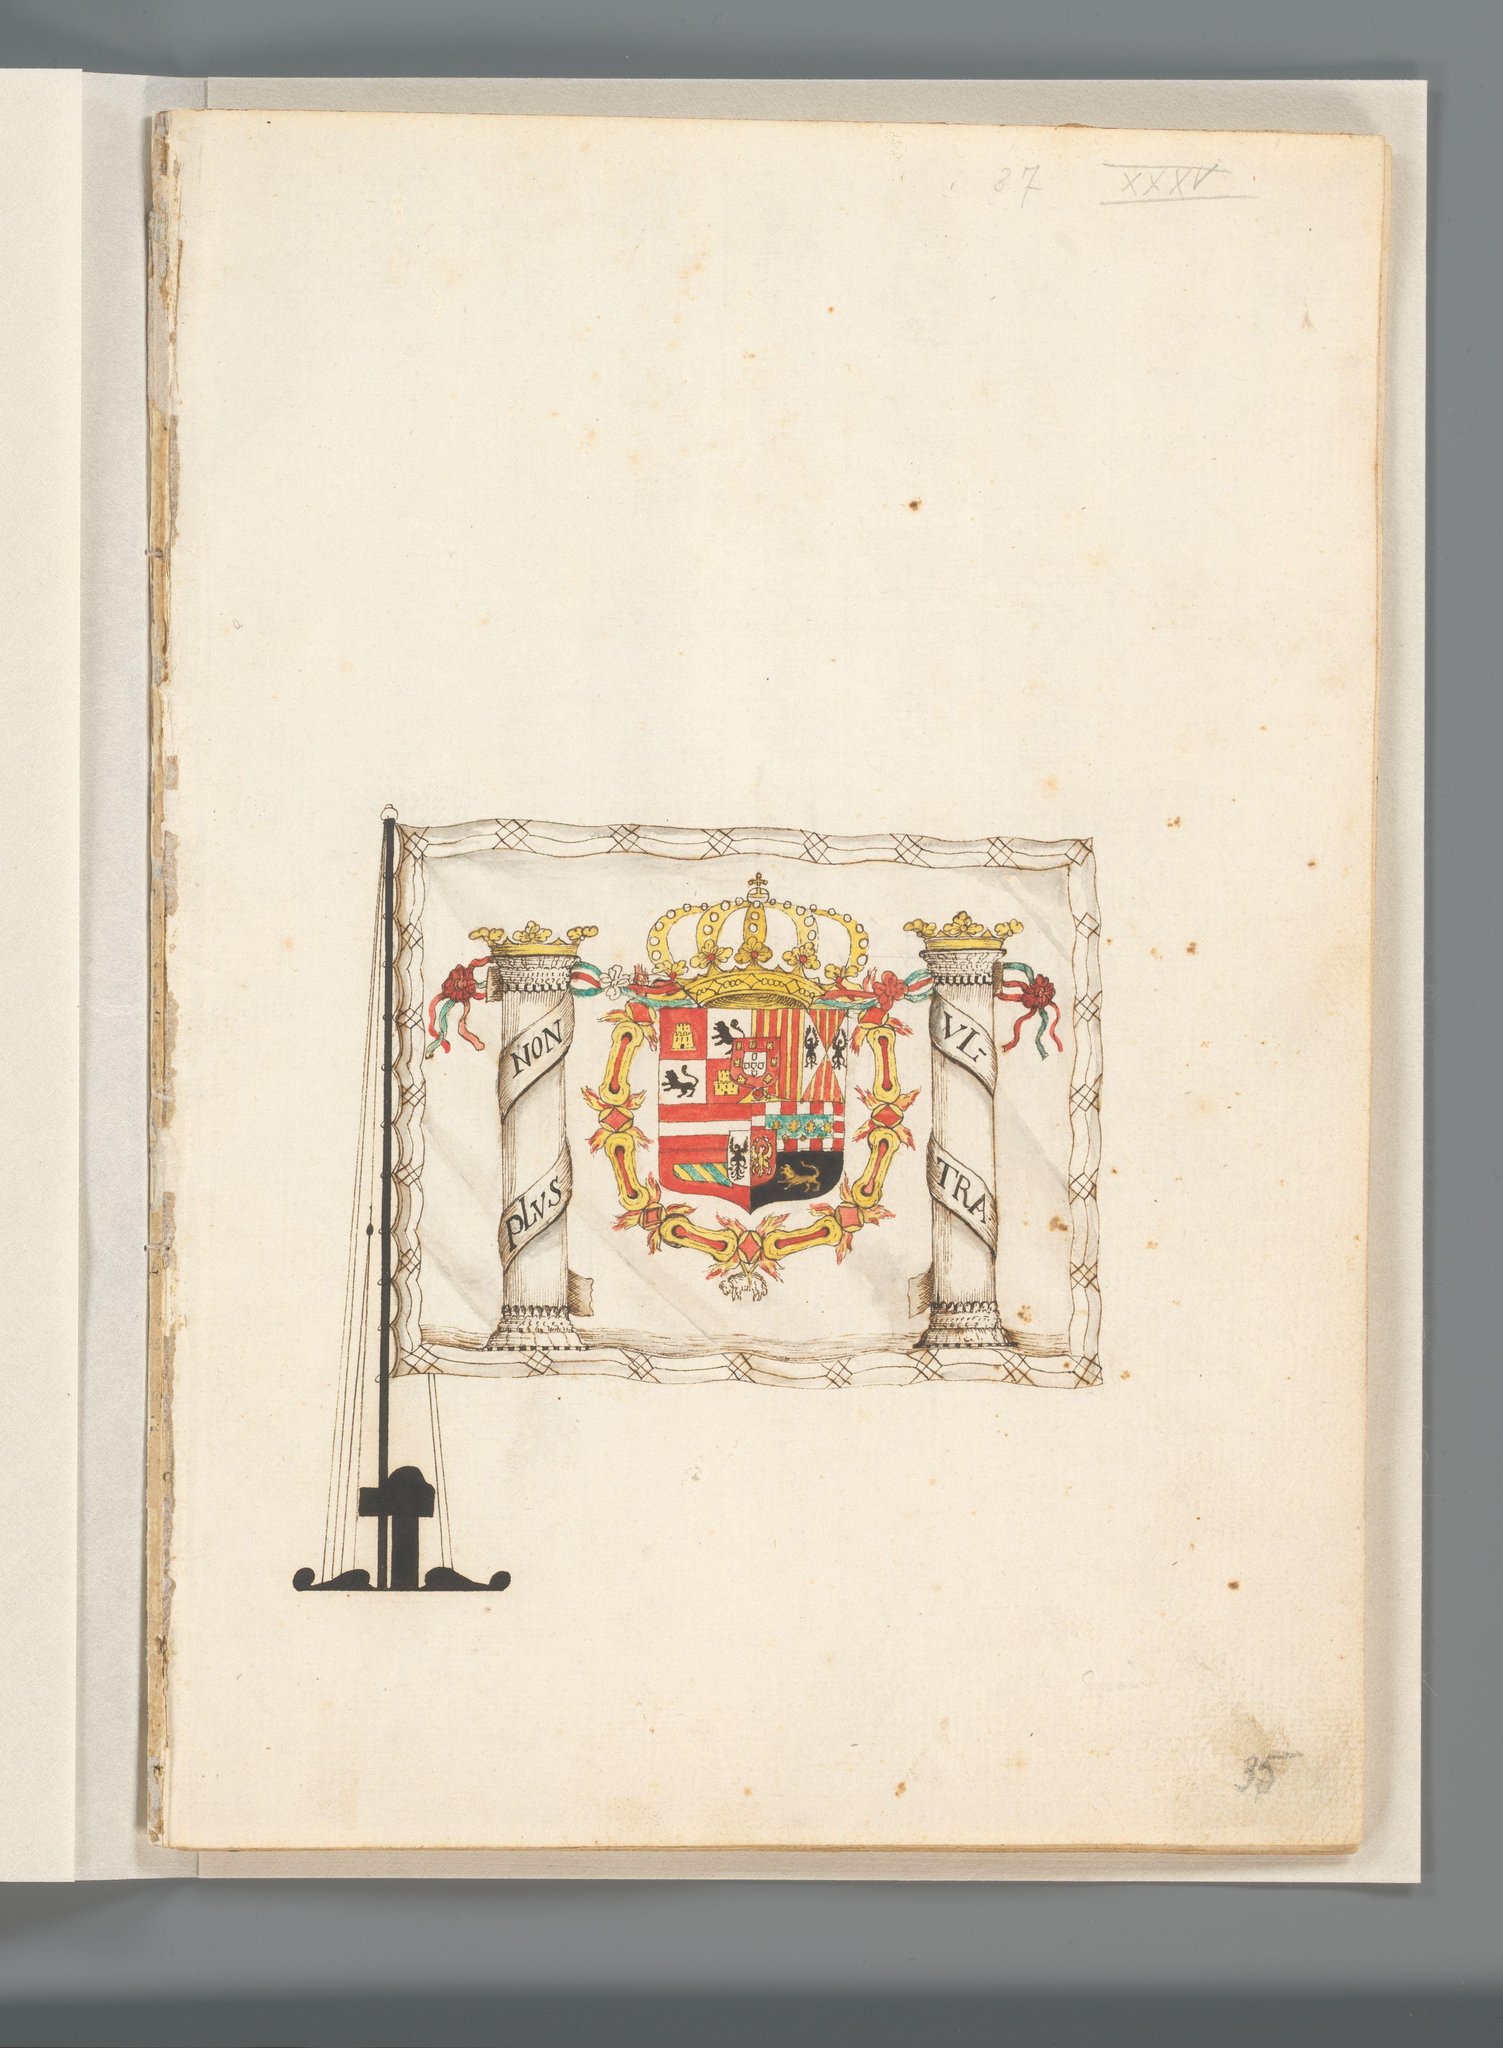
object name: drawing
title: Vlag van Spanje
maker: Anonymous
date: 1667-1670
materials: ink, paper, watercolor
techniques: brush, pen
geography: france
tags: flag, colours (as symbol of the state, etc.), spain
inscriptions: number: ‘37 / XXXV / 35’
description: Vlag van Spanje. Witte vlag met het gekroonde wapen van het Spaans-Habsburgse koningshuis, geflankeerd door een tweetal zuilen met daarop het devies 'Non Plus Ultra', en waaromheen het ordeteken van het Gulden Vlies. Vlag op vlaggensteng en mastvoet. Afgebeeld op folio 19r. Onderdeel van een vlaggenboek met vlaggen uit Europa, Noord-Afrika, Nabije en Verre Oosten.